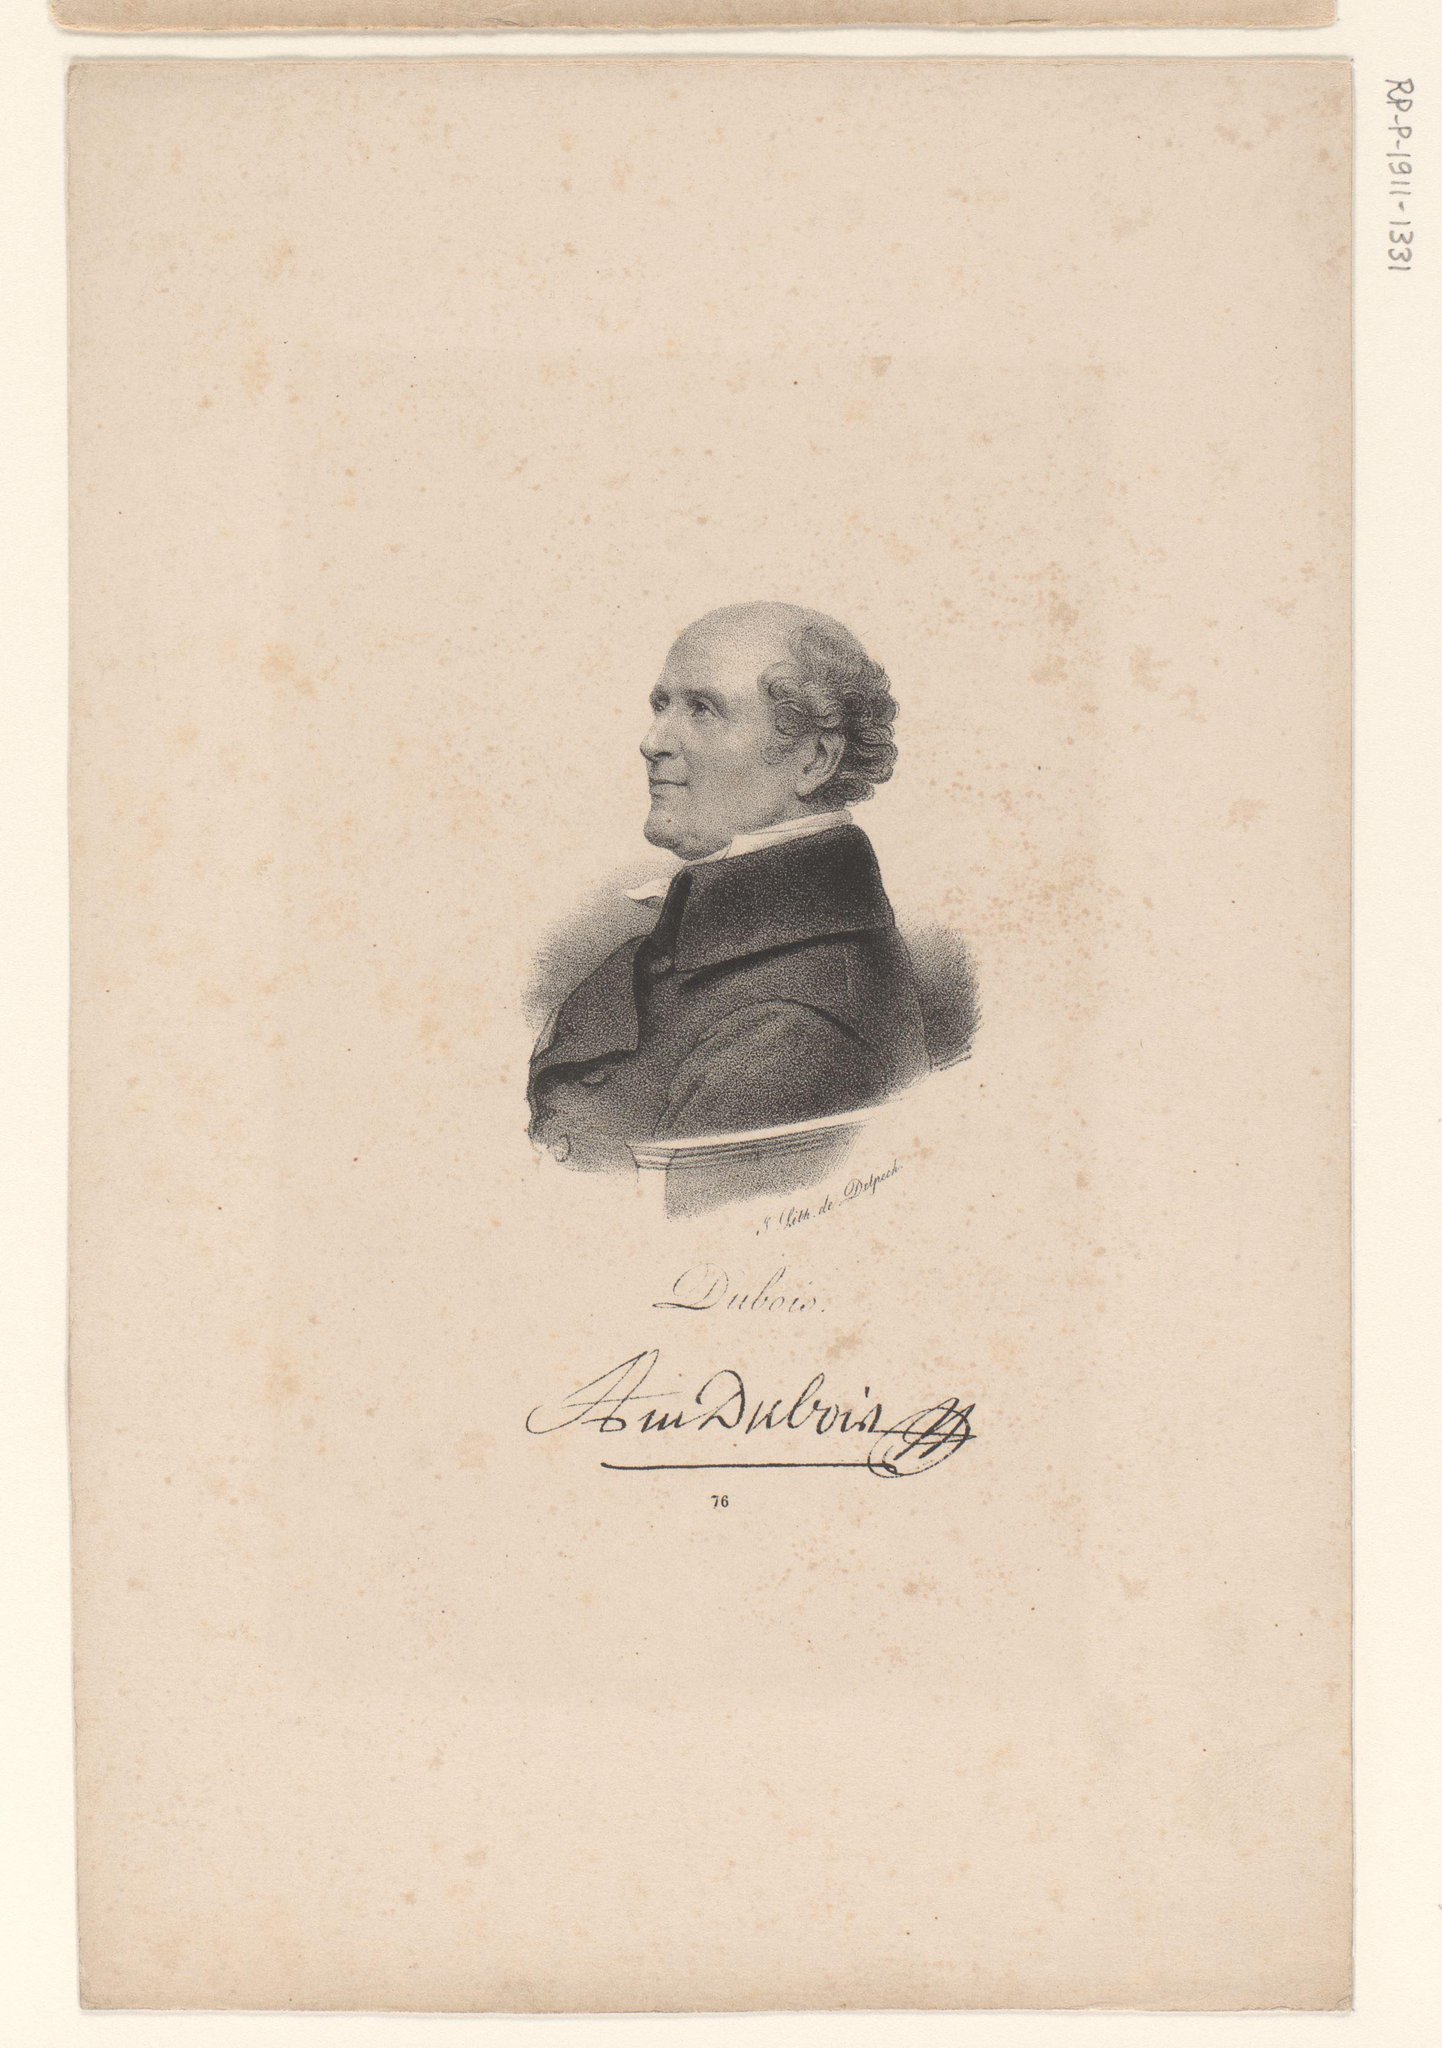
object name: print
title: Dubois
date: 1818-1842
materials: paper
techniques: lithograph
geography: paris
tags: historical persons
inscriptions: collector's mark: Lugt 2228a